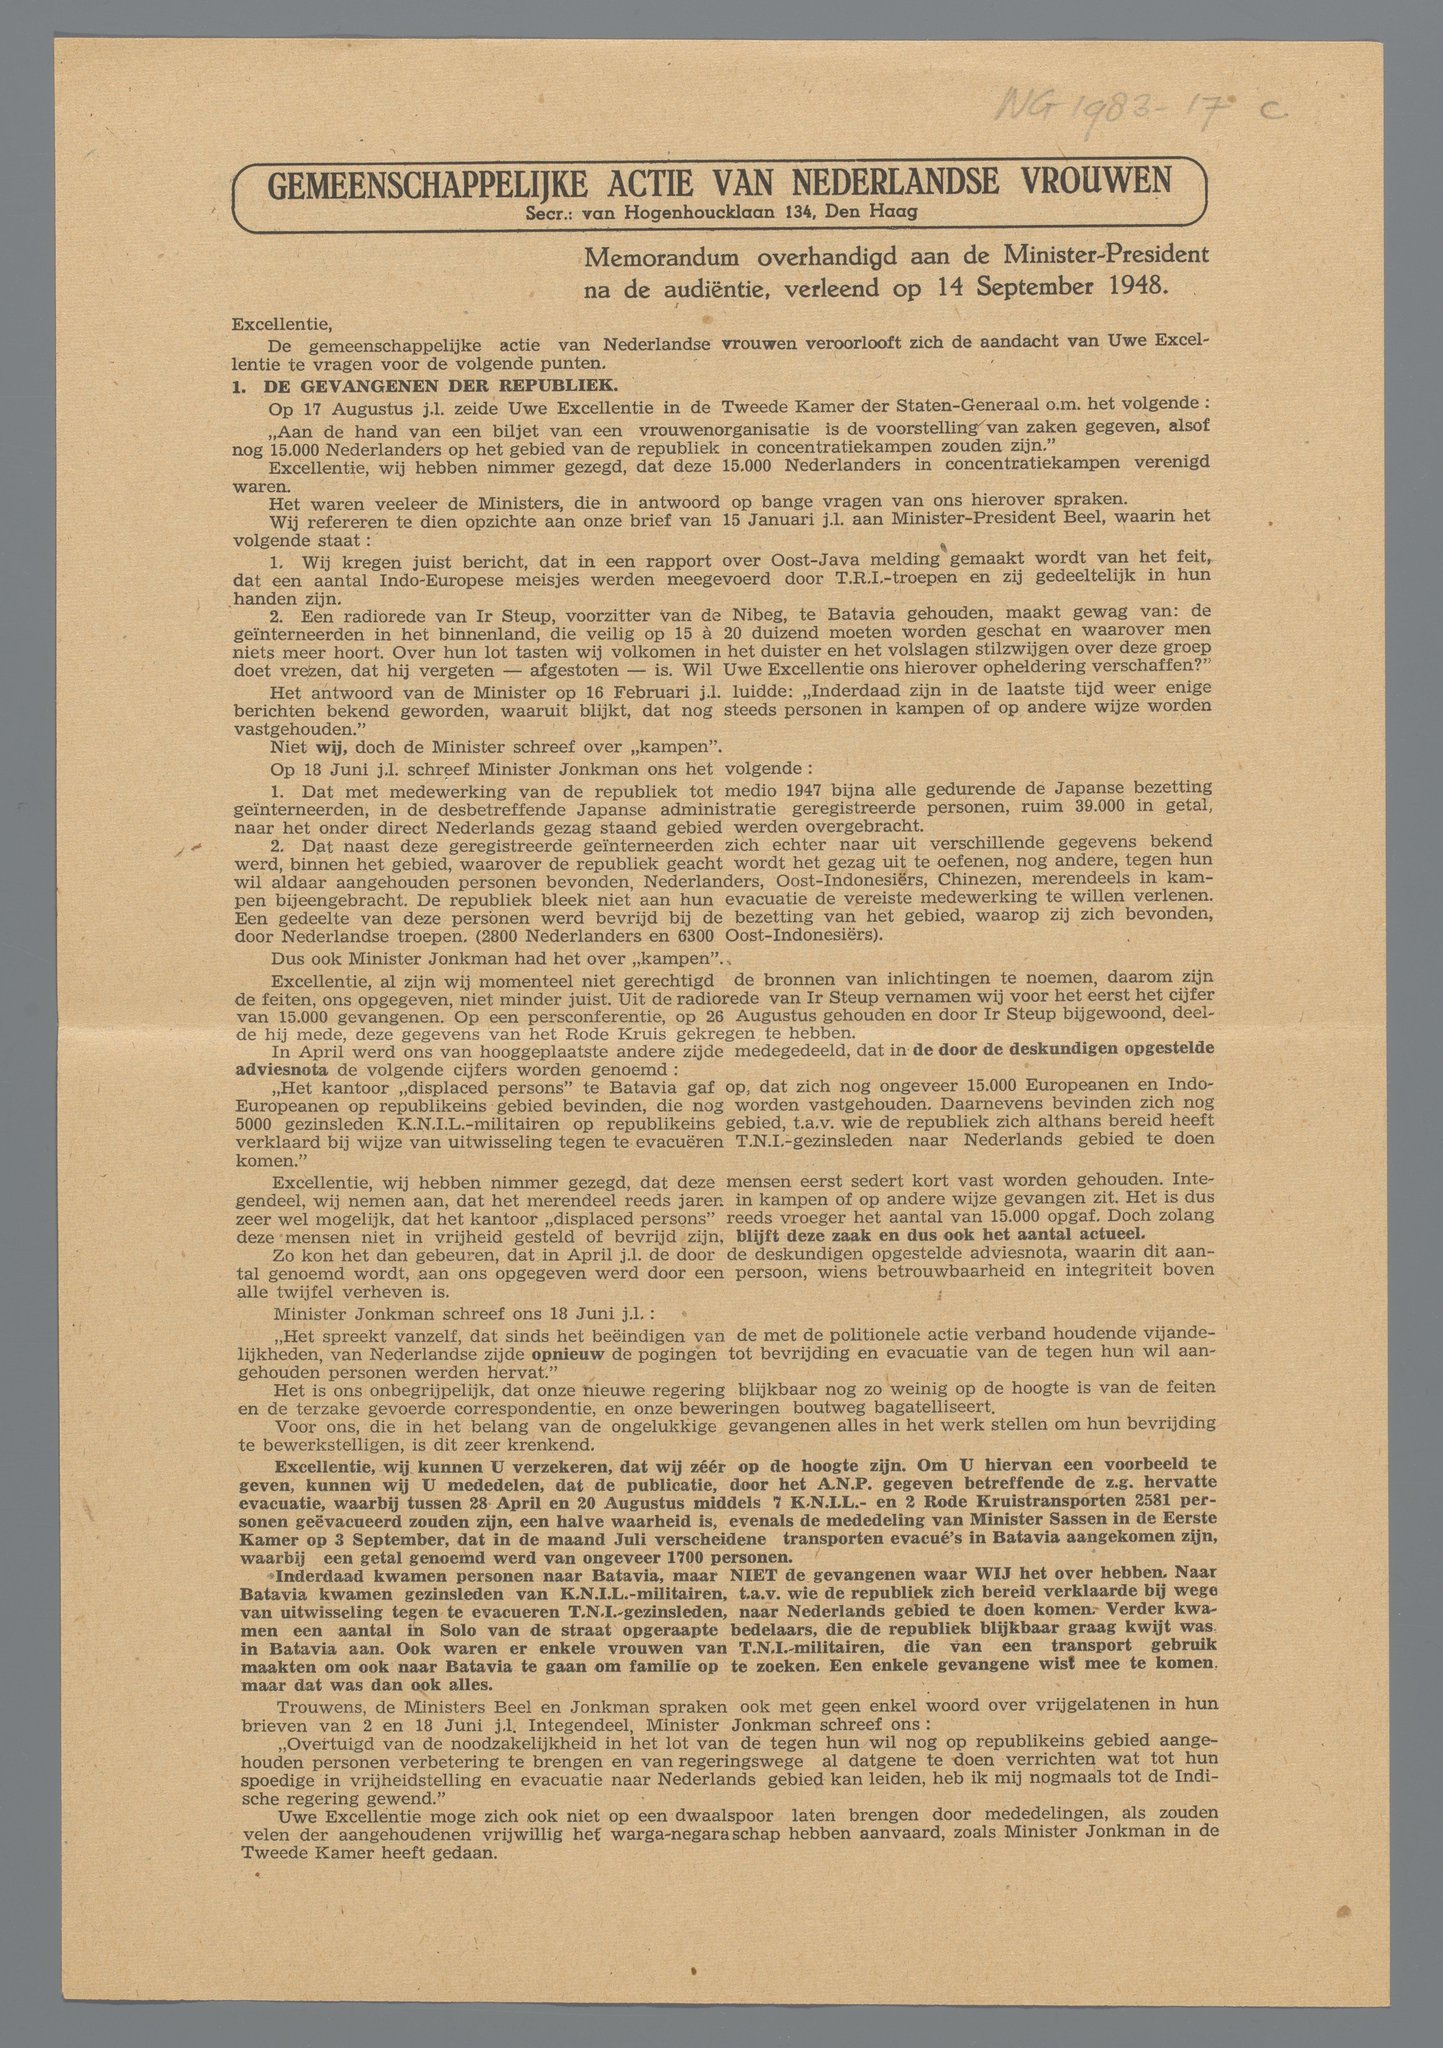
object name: pamphlet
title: Memorandum aan de Minister President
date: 1948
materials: paper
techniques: printing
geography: the hague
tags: dutch east indies, the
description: Nederlandse gevangenen in Djokja. Politionele akties in Nederlands-Indië. Deze aktie was bedoeld om de Nedelrandse overheid en het Nederlandse volk bekend te maken met het feit dat er nog 15.000 Nederlanders gevangen werden gehouden in kampen en een aantal Nederlandse vrouwen en meisjes in gedwongen concubinaat met soldaten van de republiek leefden. De Actie nam de Nederlandse regering kwalijk dat er niets aan werd gedaan.